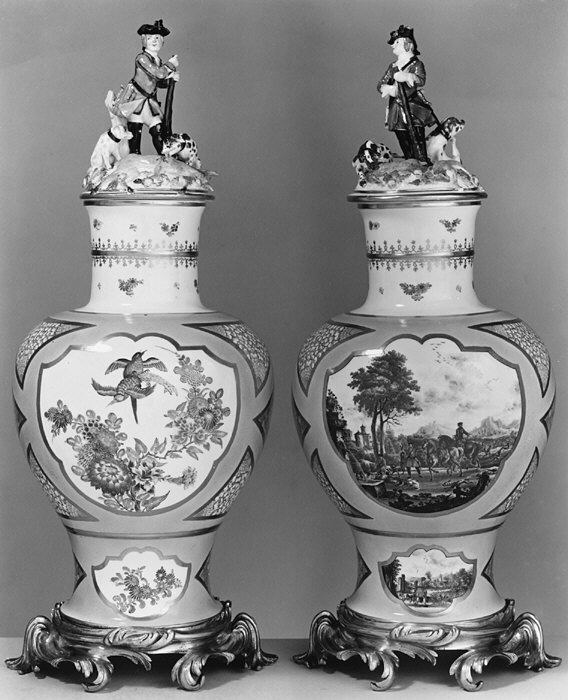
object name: vase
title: Vase (one of a pair)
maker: meissen manufactory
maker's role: manufactory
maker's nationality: german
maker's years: 1710-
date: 1740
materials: gilt bronze, hard paste porcelain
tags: birds,horses,flowers,trees